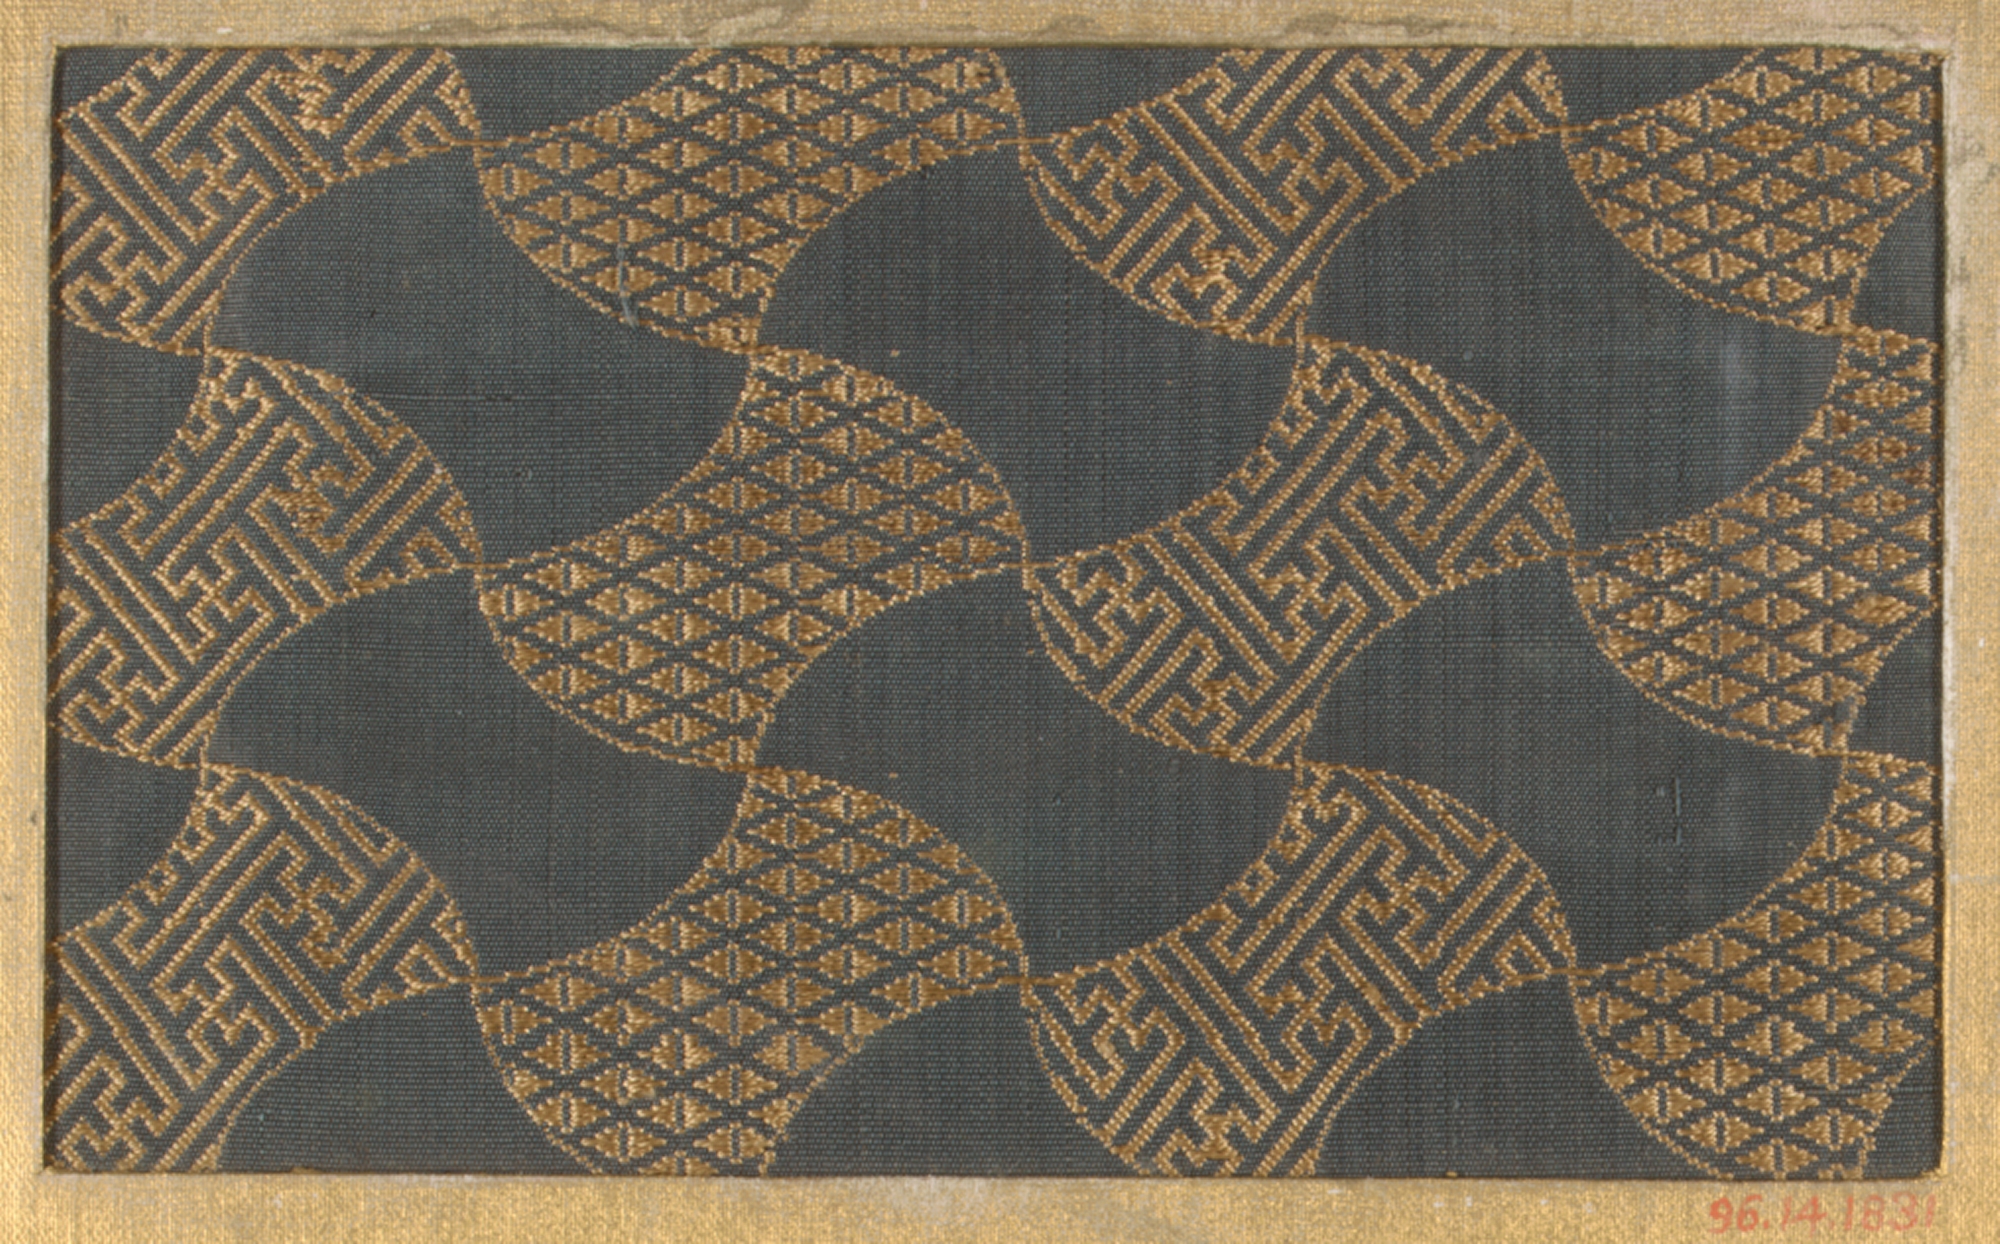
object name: piece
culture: japanese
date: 1701-1900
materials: silk